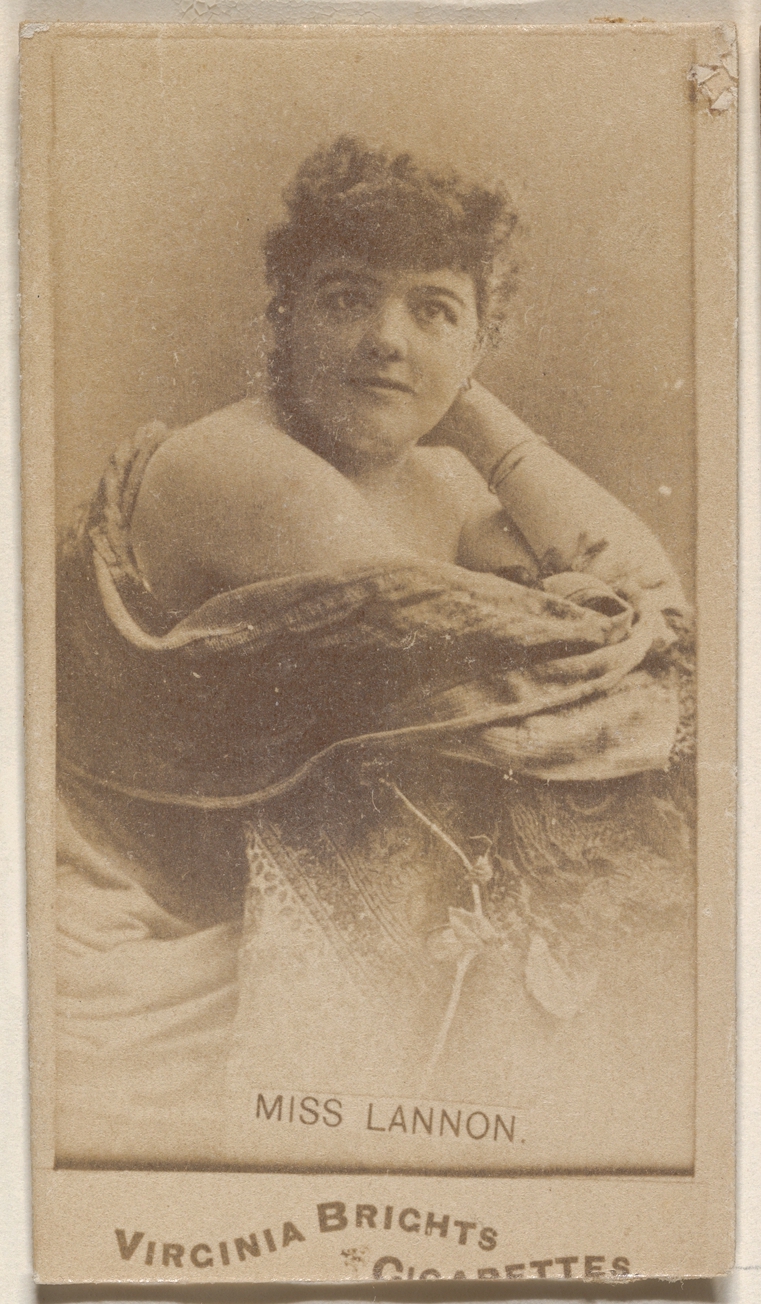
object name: photograph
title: Miss Lannon, from the Actors and Actresses series (N45, Type 1) for Virginia Brights Cigarettes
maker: allen & ginter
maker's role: publisher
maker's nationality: american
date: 1888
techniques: albumen silver print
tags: portraits,women,actresses